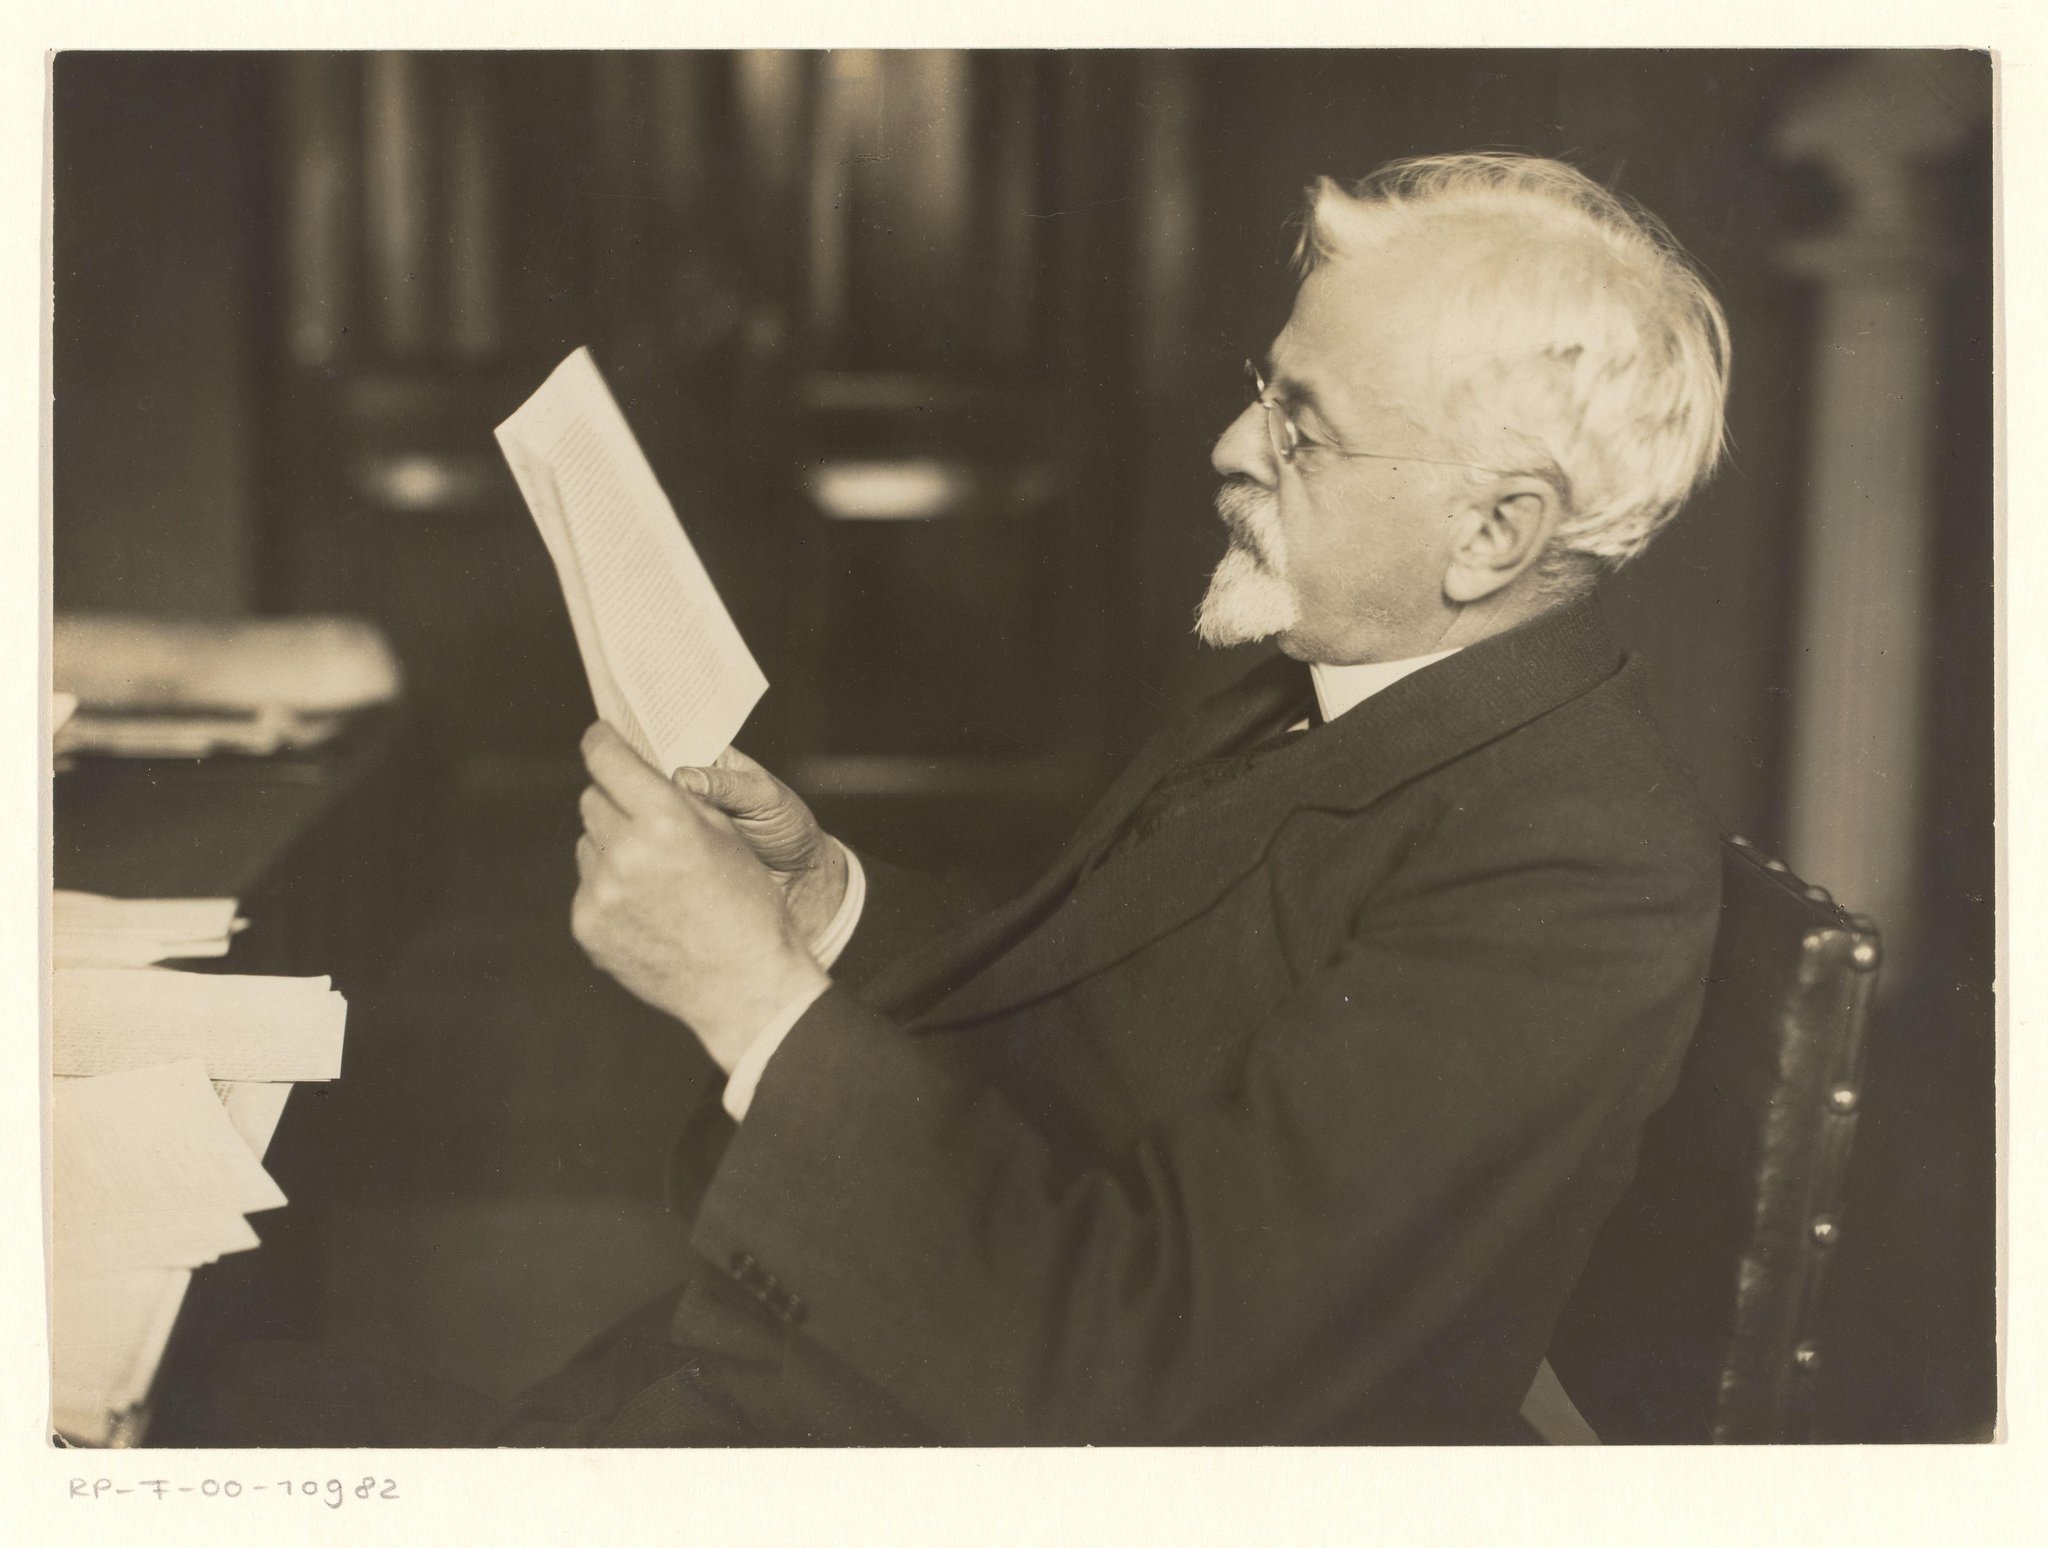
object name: photograph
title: Portret van G.T.J. de Jongh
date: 1930-1949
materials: photographic support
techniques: gelatin silver print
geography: amsterdam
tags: historical persons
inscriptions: collector's mark: Lugt 2228a, name: ‘Mr. G.T.J. de Jongh’, annotation: ‘Na gebruik terug aan/ Mr de Jongh/ 9 van Miereveldt’, :, copyright notice: ‘COPYRIGHT/ N.V. VEREENIGDE FOTOBUREAUX/ NIEUWE HEERENGRACHT 105/ AMSTERDAM’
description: De Jongh zit achter een bureau en leest een tekst die hij in zijn handen houdt.